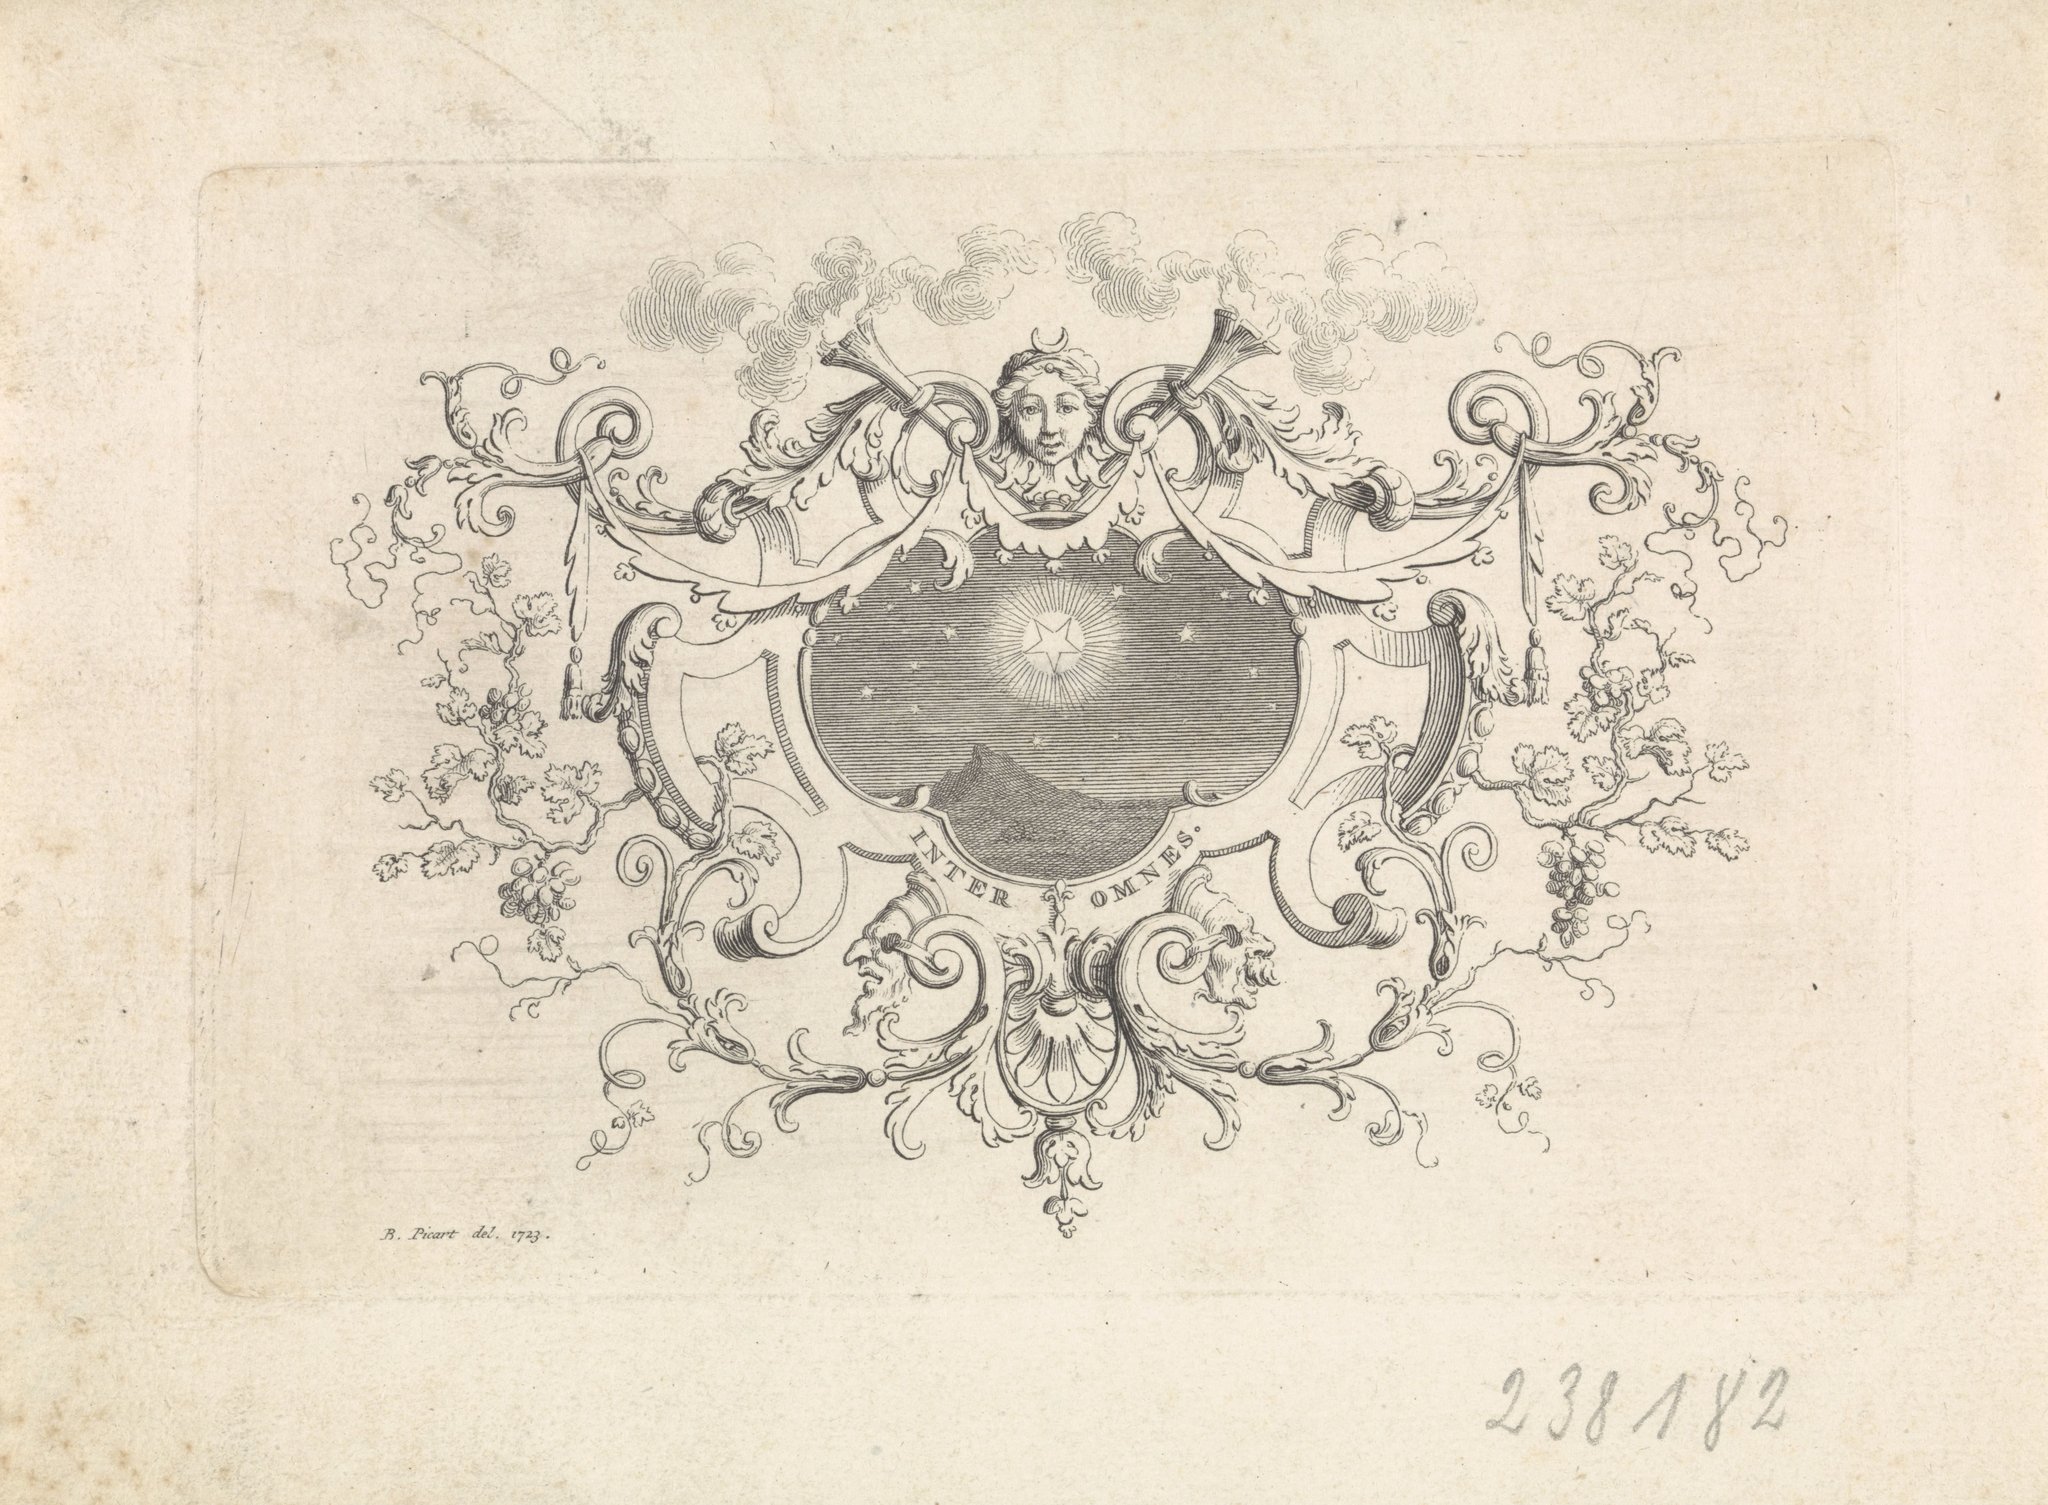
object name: print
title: Stralende ster in ornamenteel cartouche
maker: bernard picart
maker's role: draughtsman, print maker, publisher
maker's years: 1673-1733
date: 1723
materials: paper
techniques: engraving, etching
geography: amsterdam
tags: mask, mascaron ~ ornament, stars, foliage, tendrils, branches ~ ornament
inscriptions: collector's mark: Lugt 2228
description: Prent ook gebruikt in: Impostures innocentes ou recueil d'estampes d'après divers peintres illustres... etc. gravées par Bernard Picart avec son éloge historique et le catalogue de ses ouvrages. Amsterdam: weduwe Bernard Picart, 1734. Vergelijk met de tekening onder objectnummer RP-T-1951-105 uit 1711.